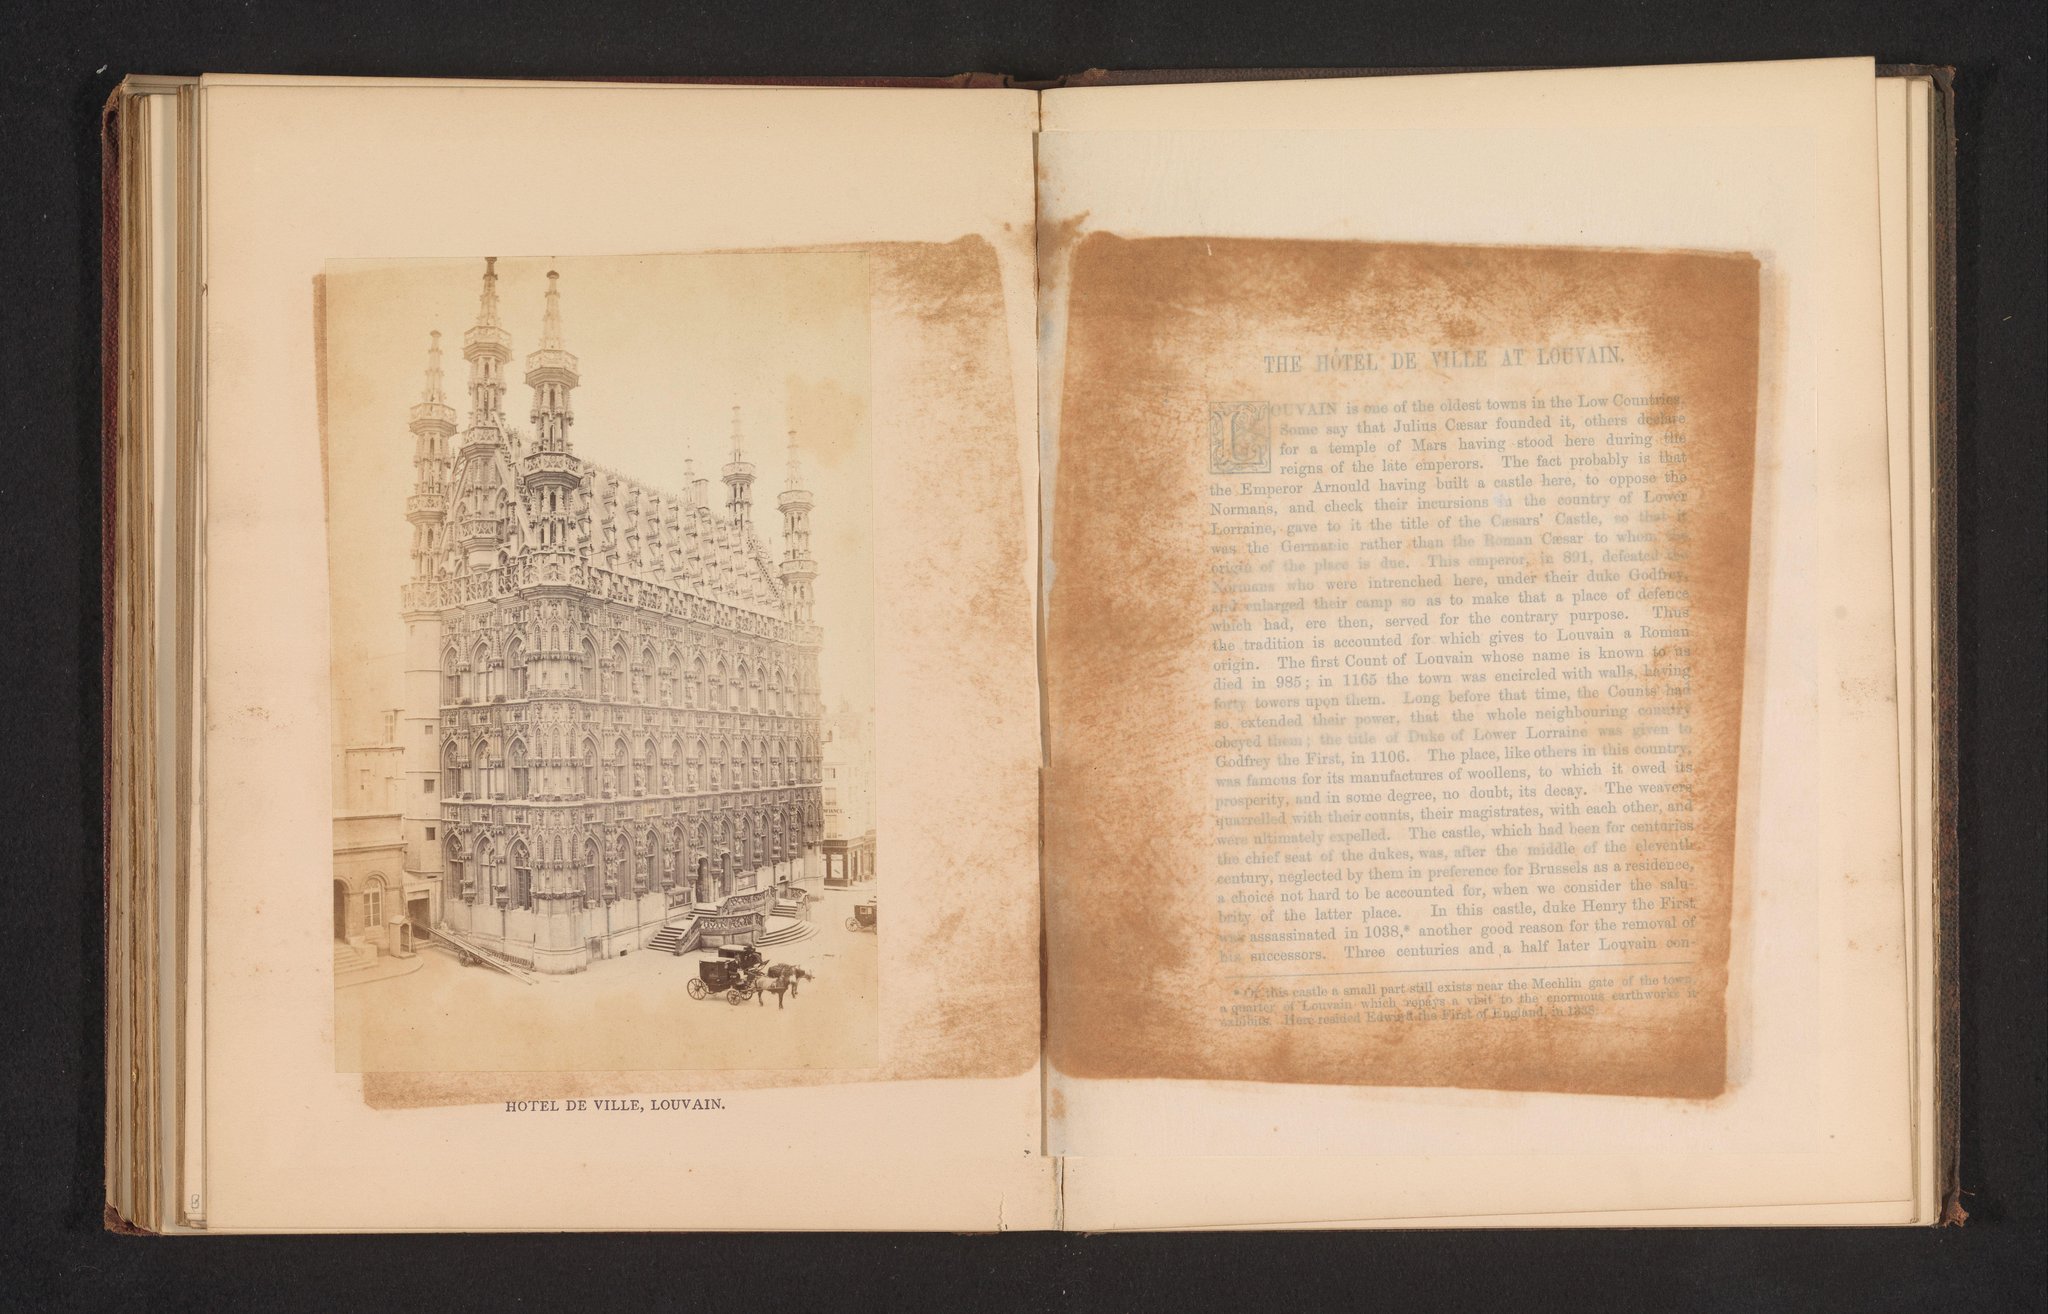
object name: photograph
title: Hotel de ville, Louvain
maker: Anonymous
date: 1856-1866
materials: photographic support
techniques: albumen print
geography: leuven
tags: townhall, façade (of house or building)